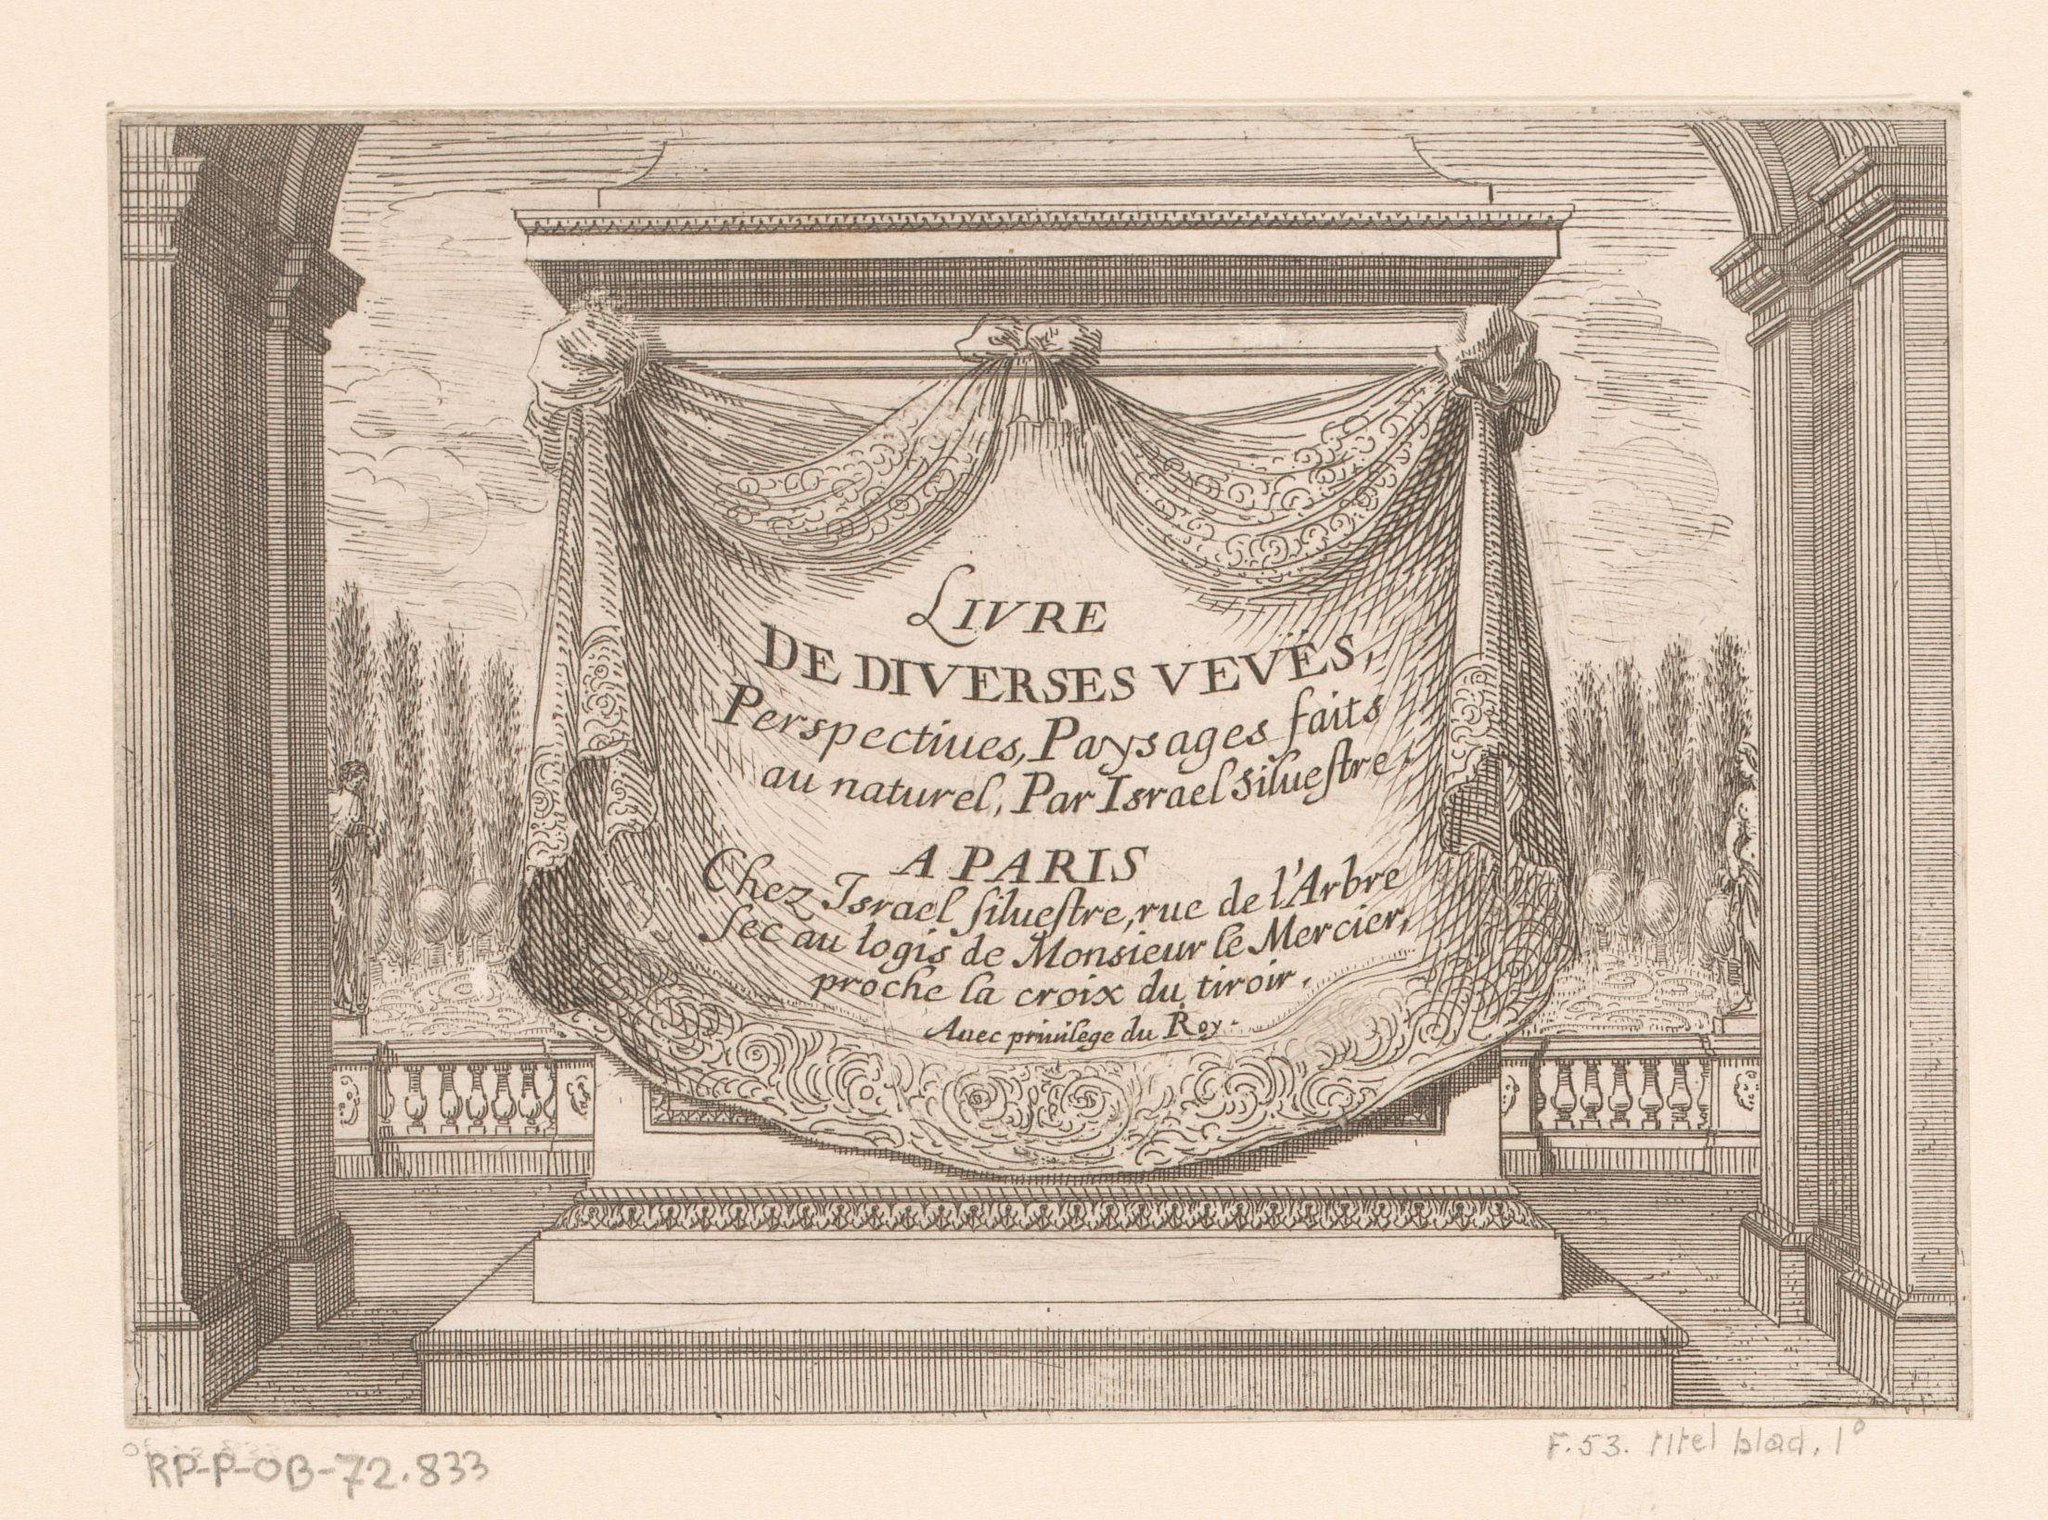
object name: print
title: Livre de Diverses Veues, Perspectives, Paysages faits au naturel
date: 1631-1691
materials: paper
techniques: engraving, etching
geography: paris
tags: french or architectonic garden; formal garden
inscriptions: collector's mark: Lugt 240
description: Prent maakt deel uit van een genummerde serie van negen prenten, maar de nummers zijn afgesneden. Dit is de titelprent.